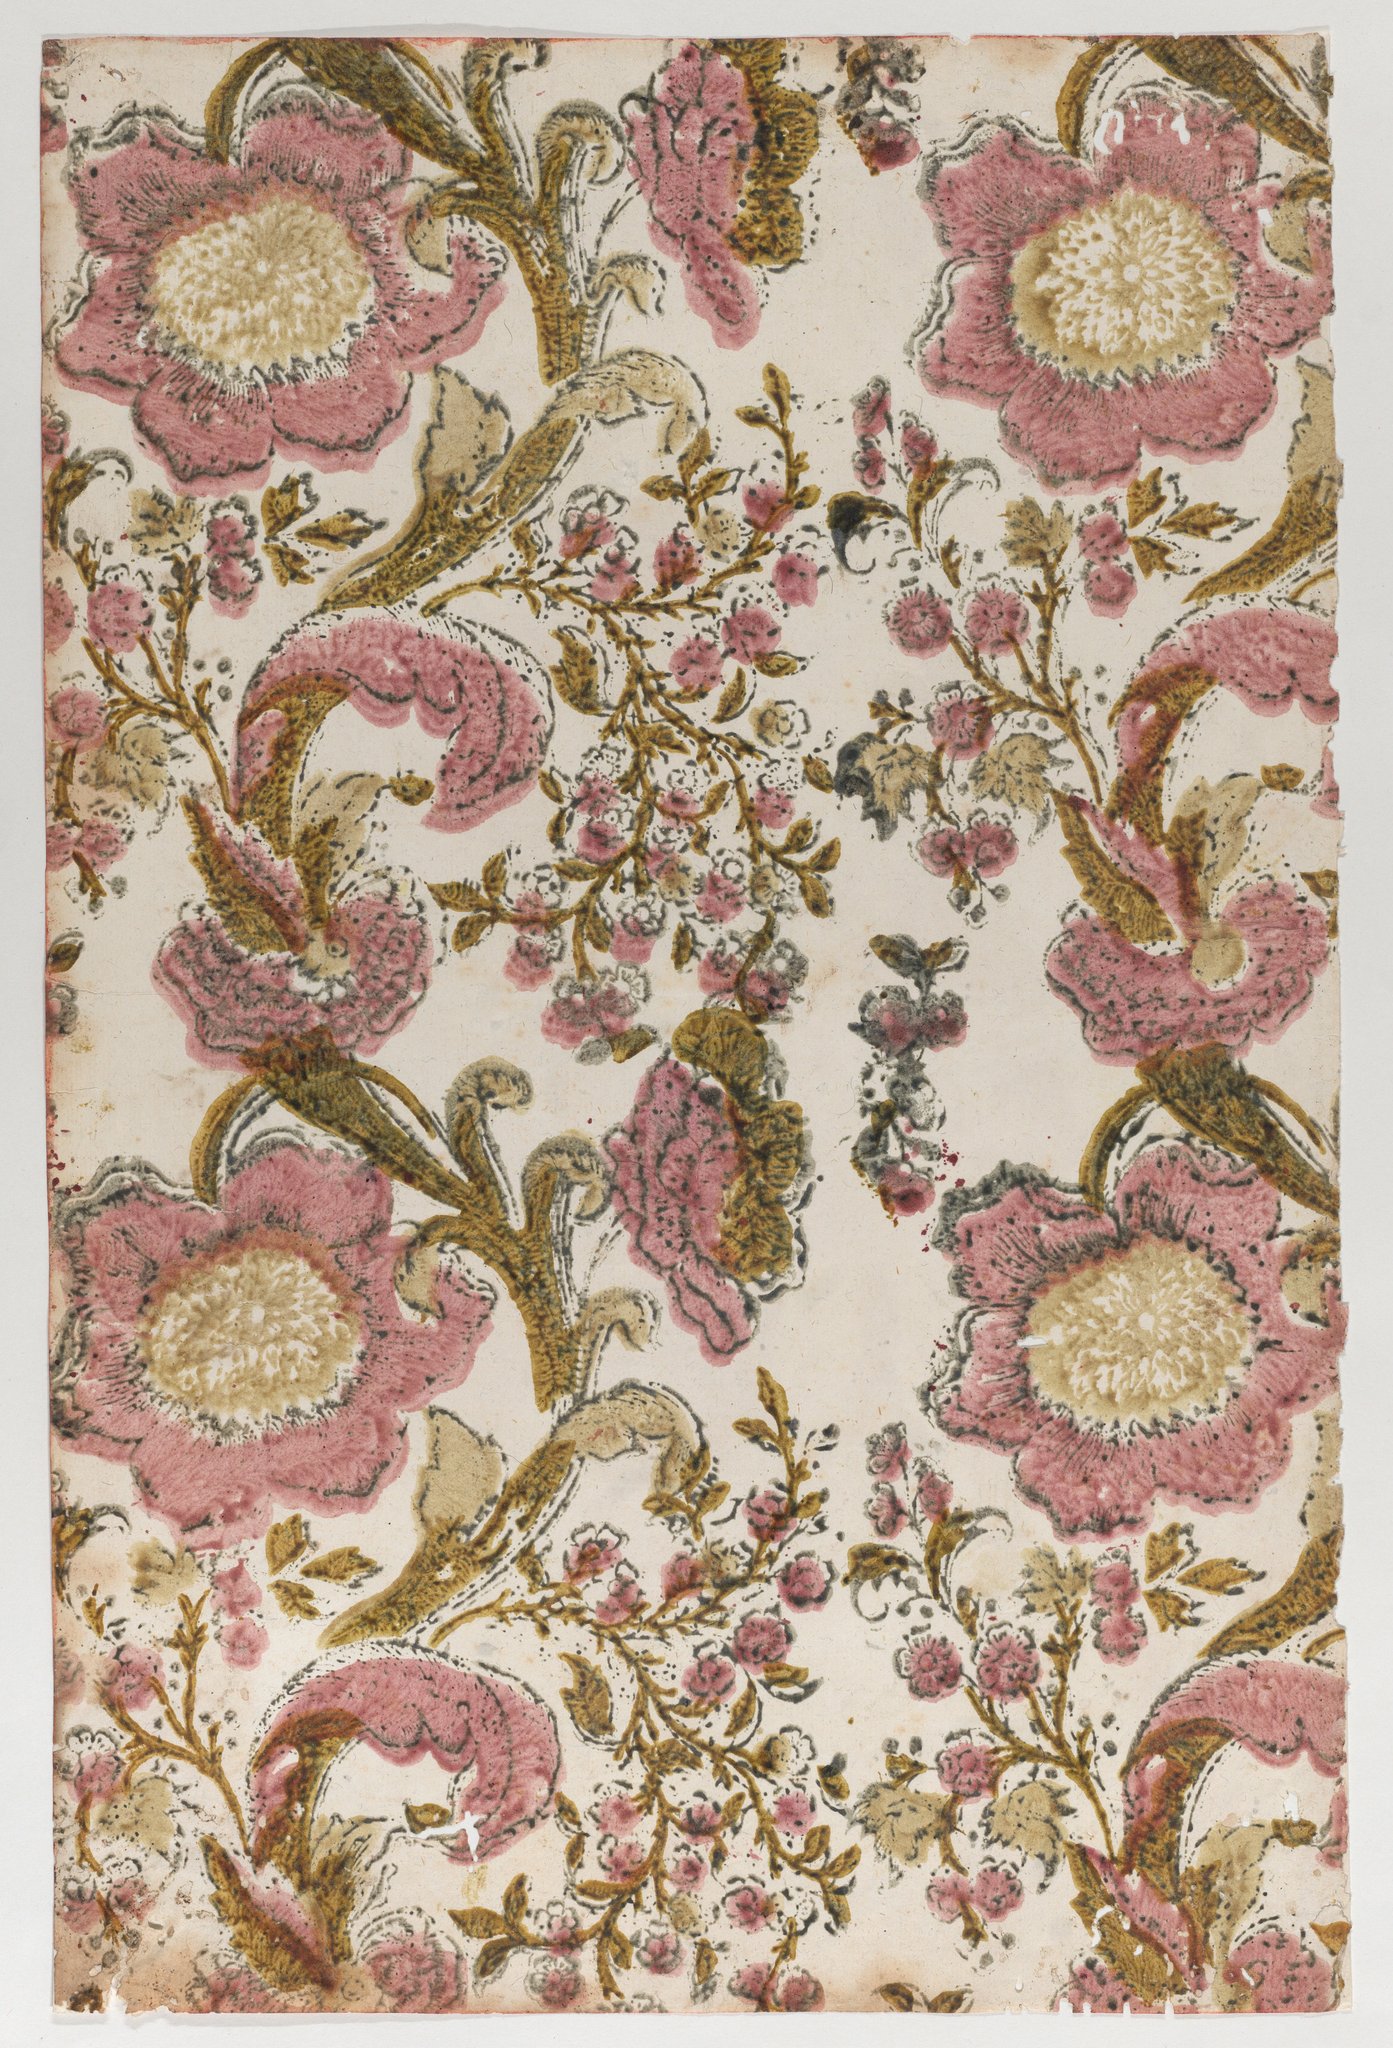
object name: print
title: Sheet with overall floral pattern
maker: Anonymous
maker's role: artist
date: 1701-1800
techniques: relief print